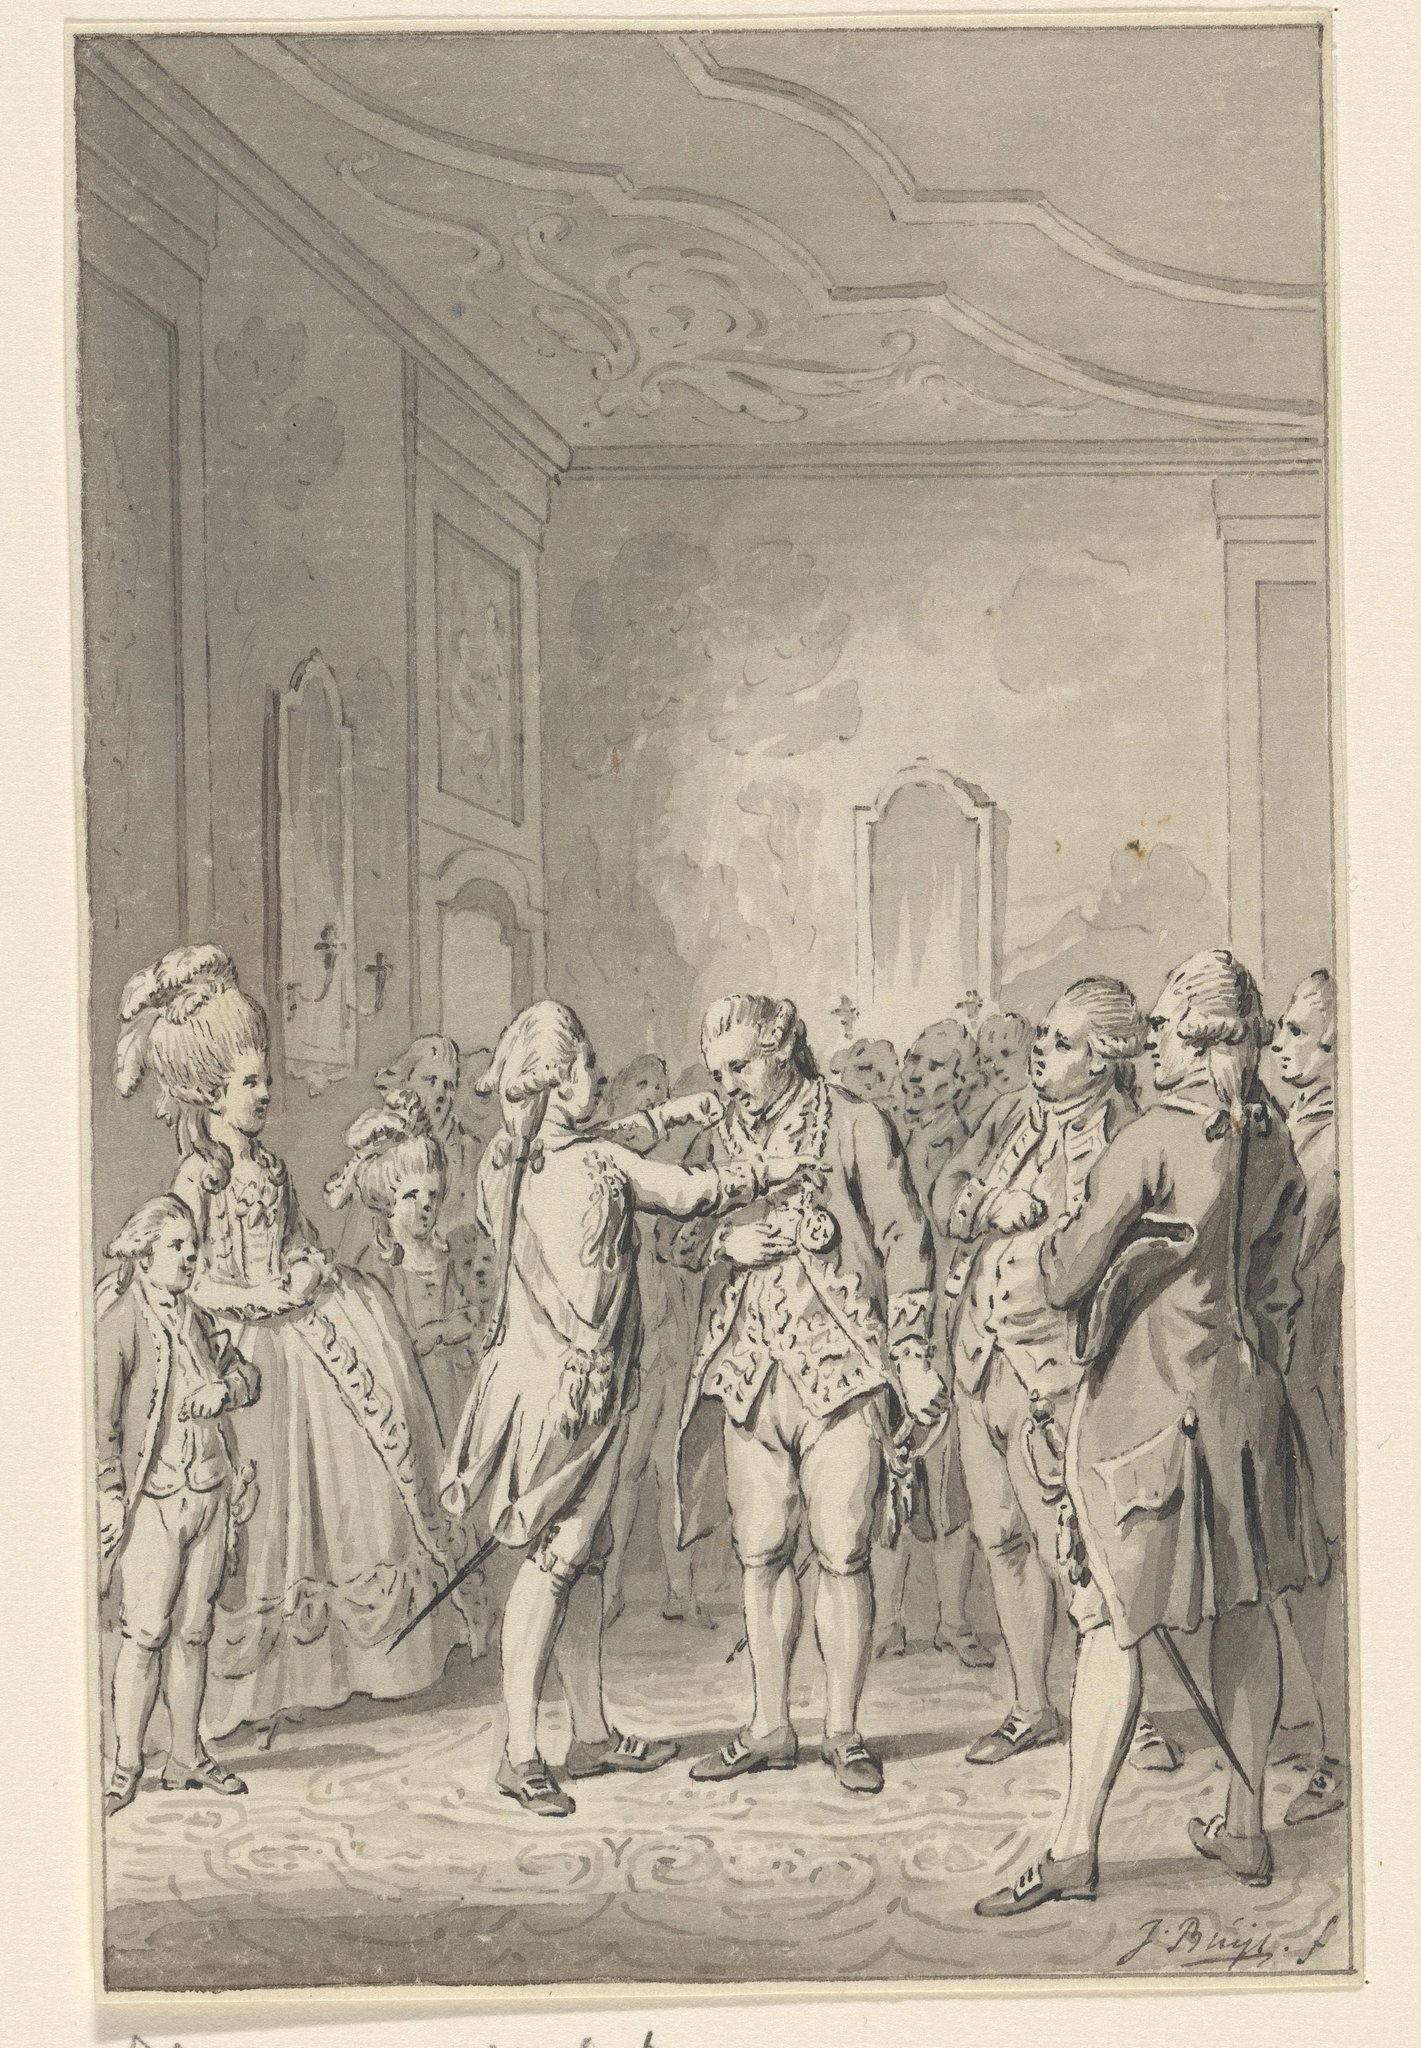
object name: design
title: Willem V vereert de helden van de zeeslag bij Doggersbank, 1781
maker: jacobus buys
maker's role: draughtsman, print maker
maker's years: 1724-1801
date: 1786-1788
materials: ink, paper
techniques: brush, pen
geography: northern netherlands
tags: the hague, william v (prince of orange), johan arnold zoutman, medals and other marks of military honour (+ sailing-ships), ruler giving mark of honour, decorations, honours (as symbols of the state, etc.)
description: Prins Willem V beloont op 30 november schout-bij-nacht Johan Zoutman met een gedenkpenning aan een gouden ketting, na zijn overwinning in de zeeslag bij Doggersbank tussen de Nederlandse en de Britse vloot op 5 augustus 1781. Ontwerp voor een prent.